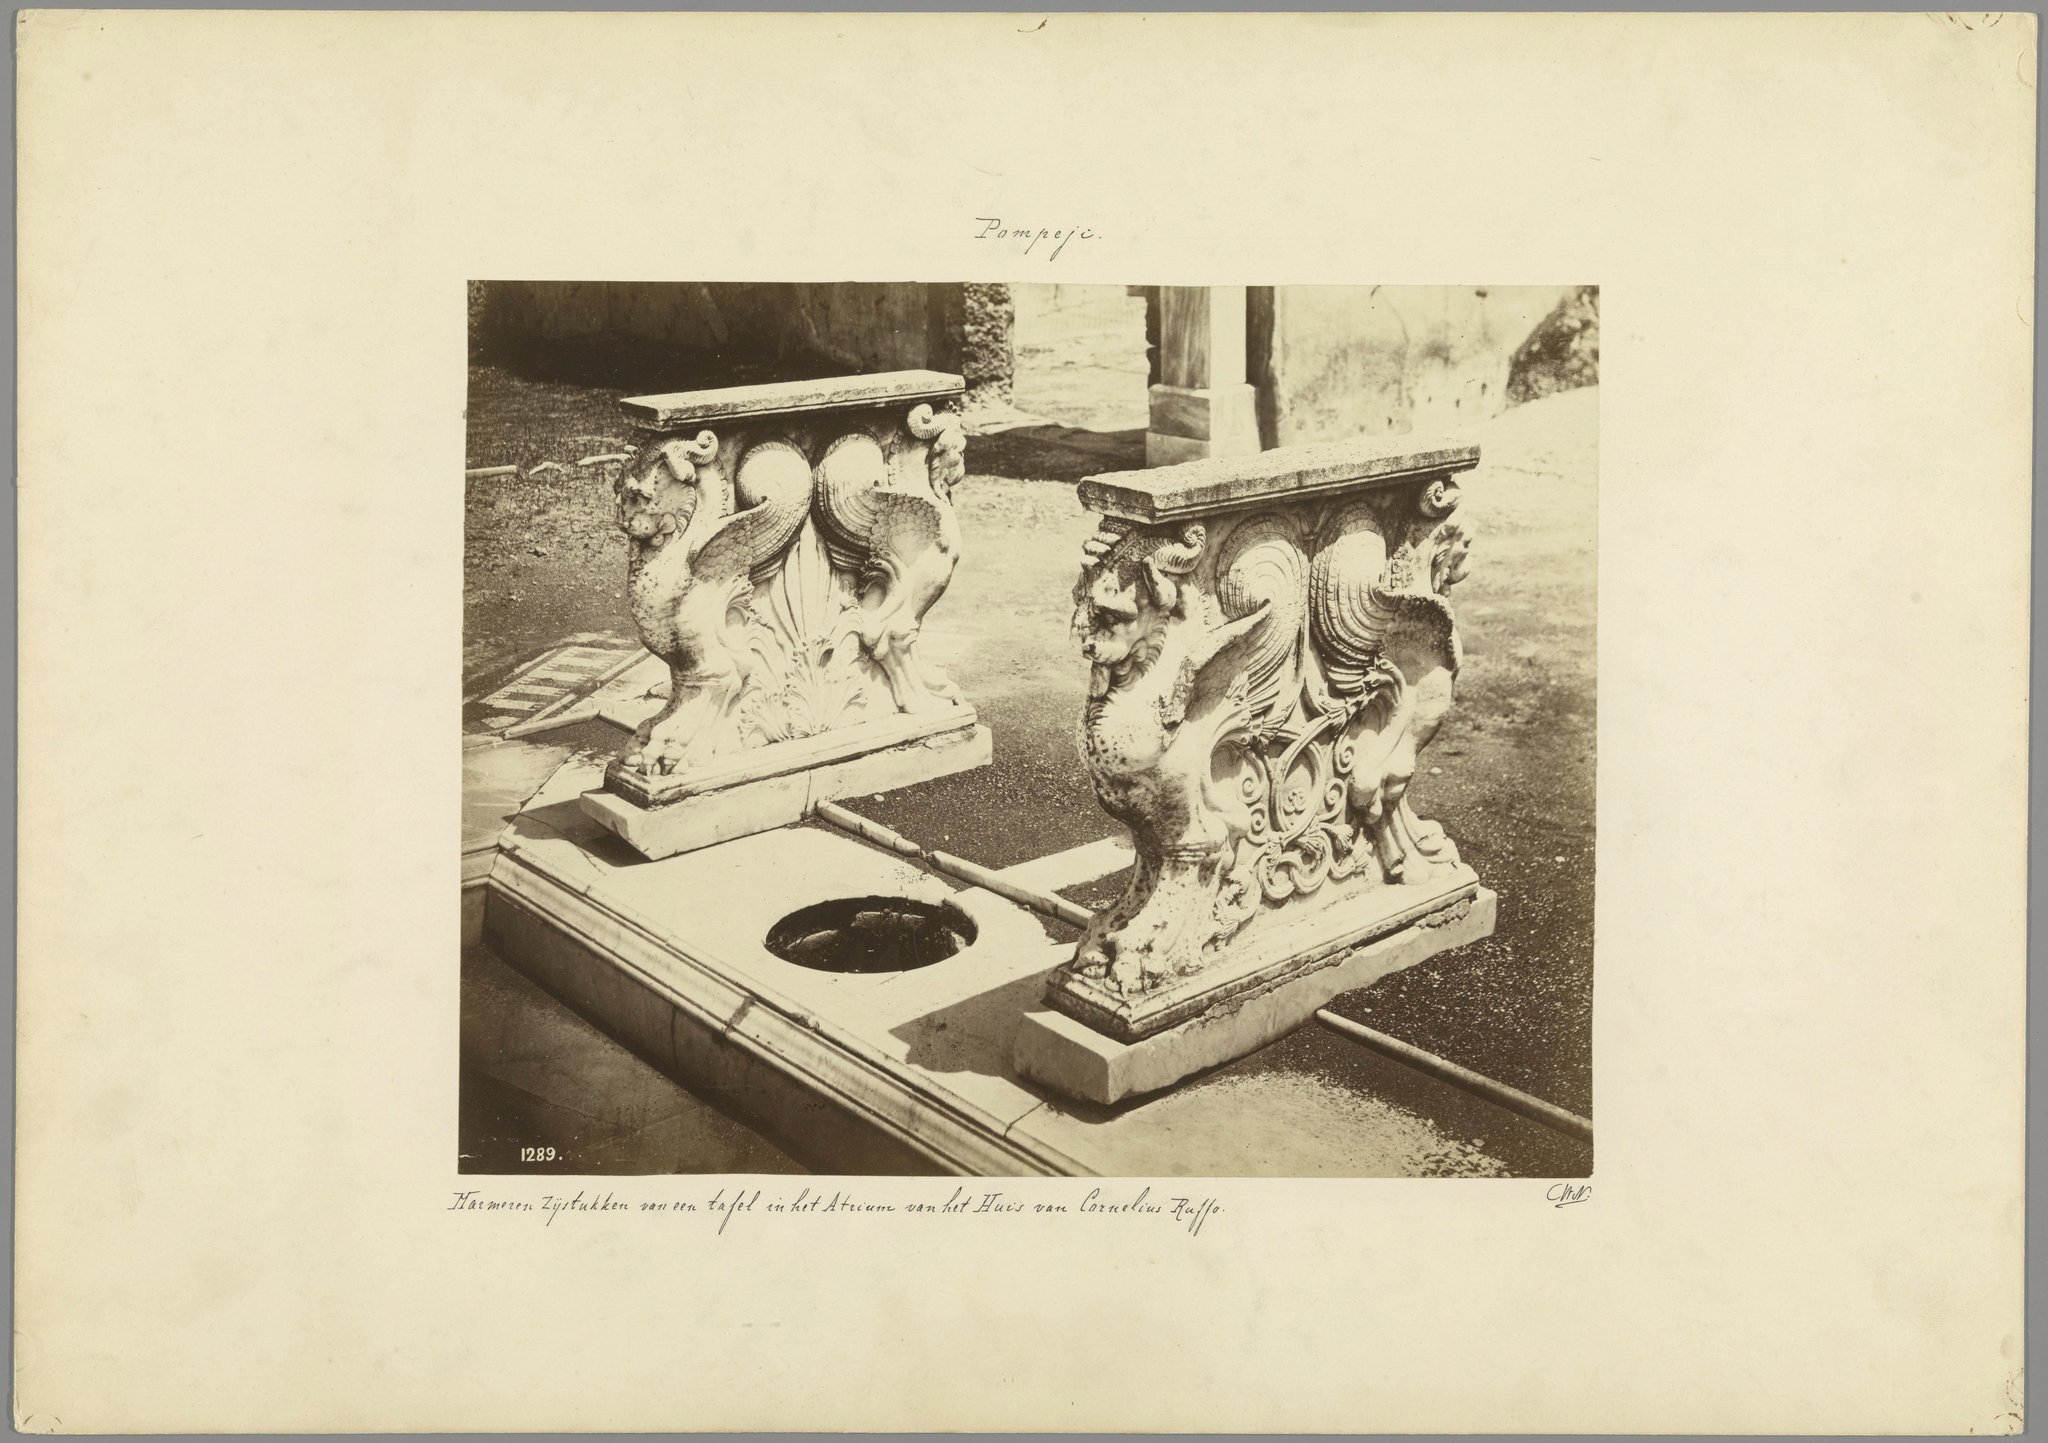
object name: photograph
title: Marmeren tafelpoten in het Casa di Cornelio Rufo te Pompeï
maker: Anonymous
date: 1875-1900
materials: cardboard, photographic support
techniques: albumen print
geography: casa di cornelio rufo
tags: ornament ~ hybrid animals, table (+ broken, damaged), interior of the house, sculpture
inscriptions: inscription: ‘Pompeji. Marmeren zijstukken van een tafel in het Atrium van het Huis van Cornelius Ruffo.’, number: ‘1289.’, collector's mark: ‘KUNSTNIJVERHEIDSCHOOL QUELLINUS AMSTERDAM FRANS HALSSTRAAT 14.’, collector's mark: ‘INSTITUUT VOOR KUNST- NIJVERHEIDSONDERWIJS GABRIËL METSUSTRAAT No. 16. AMSTERDAM’, inscription: ‘CWN.’